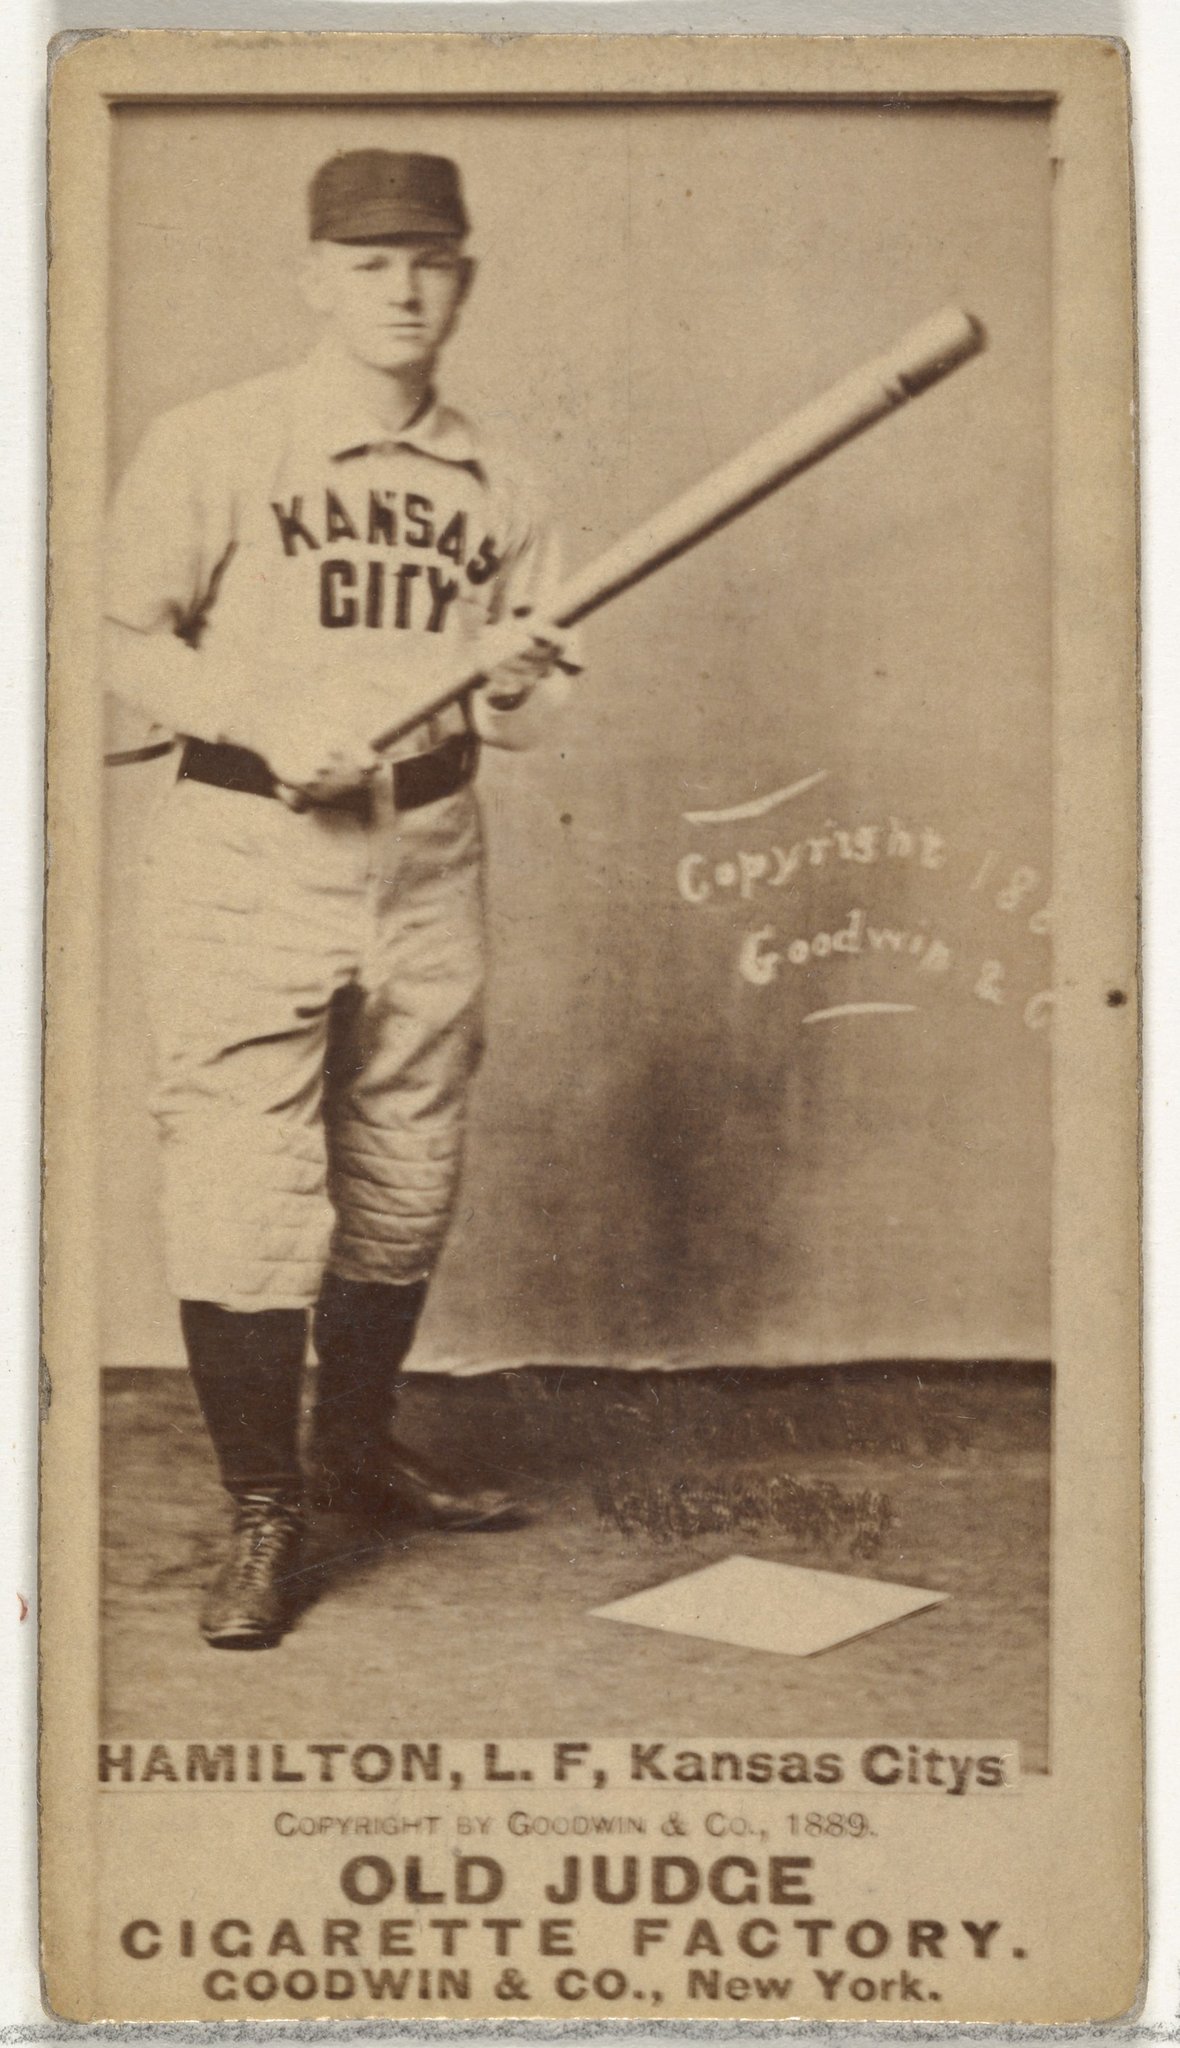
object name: baseball card, photograph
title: William Robert "Sliding Billy" Hamilton, Left Field, Kansas City Cowboys, from the Old Judge series (N172) for Old Judge Cigarettes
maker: goodwin & company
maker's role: publisher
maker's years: 1850-1950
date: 1889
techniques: albumen silver print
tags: men,portraits,baseball,athletes